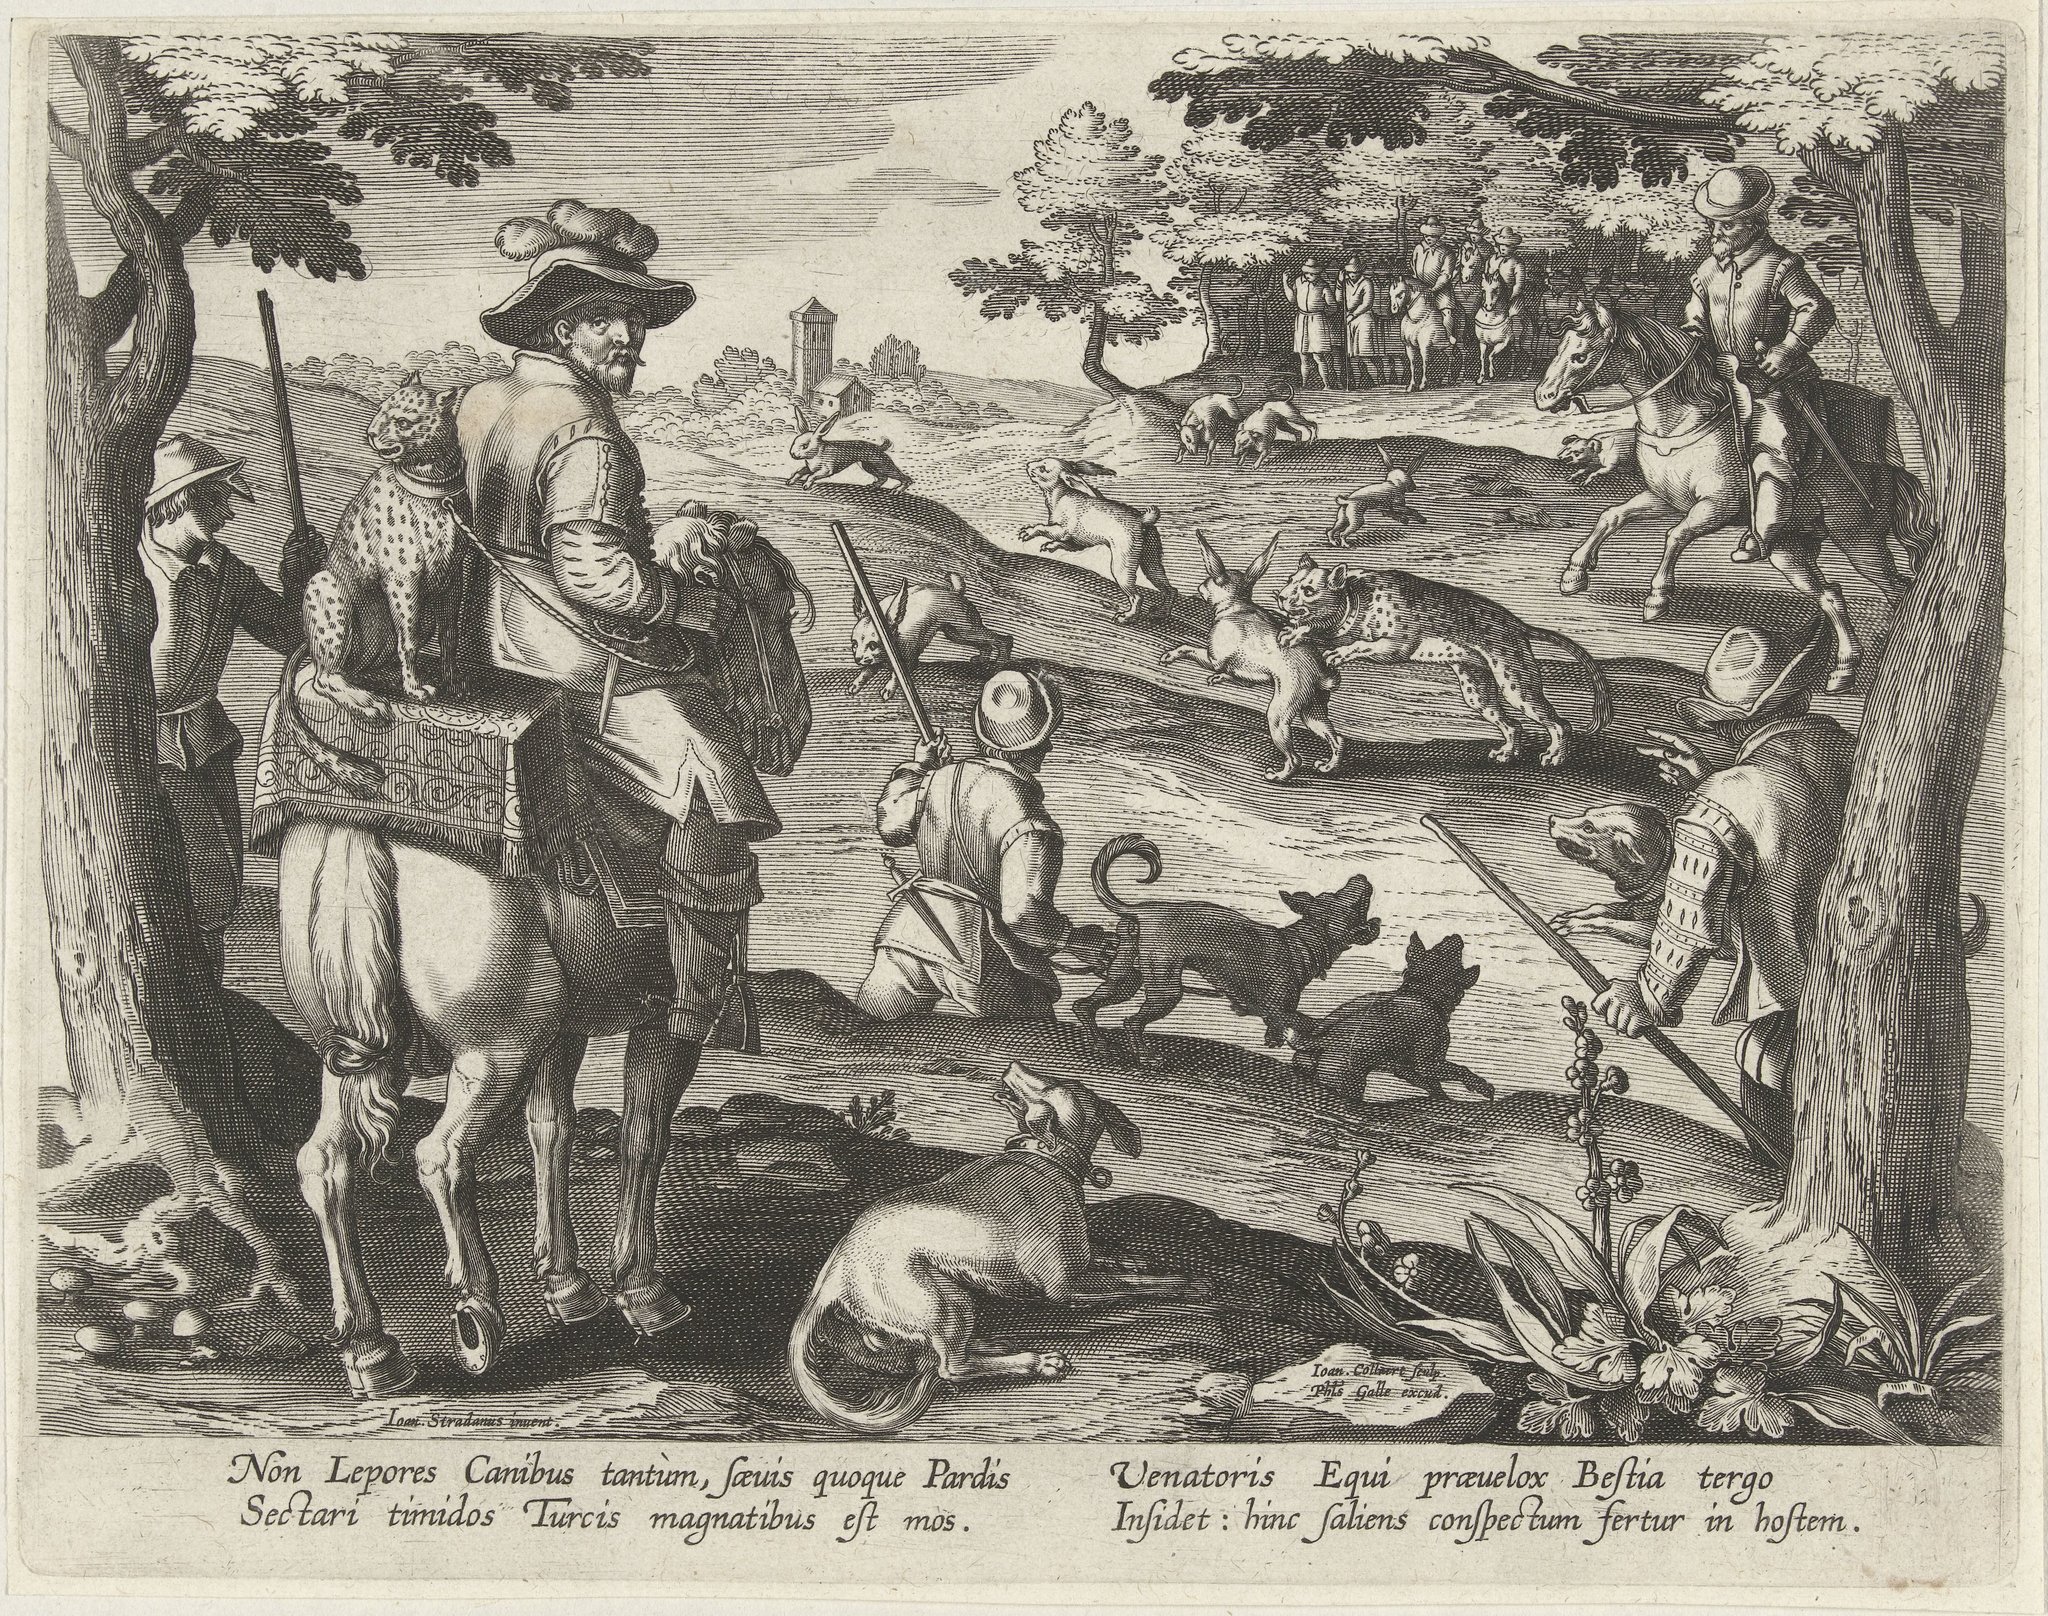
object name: print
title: Jachttaferelen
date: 1594-1598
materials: paper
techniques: engraving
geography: antwerp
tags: rodents: hare, hare-hunting, rabbit-hunting (+ hunting with cheetahs (hunting leopards))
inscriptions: collector's mark: Lugt 240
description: Een luipaard jaagt achter enkele hazen. Op de voorgrond een jager te paard. Achter op zijn zadel zit een luipaard. De prent heeft een Latijns onderschrift en is deel van een serie over jachttaferelen.